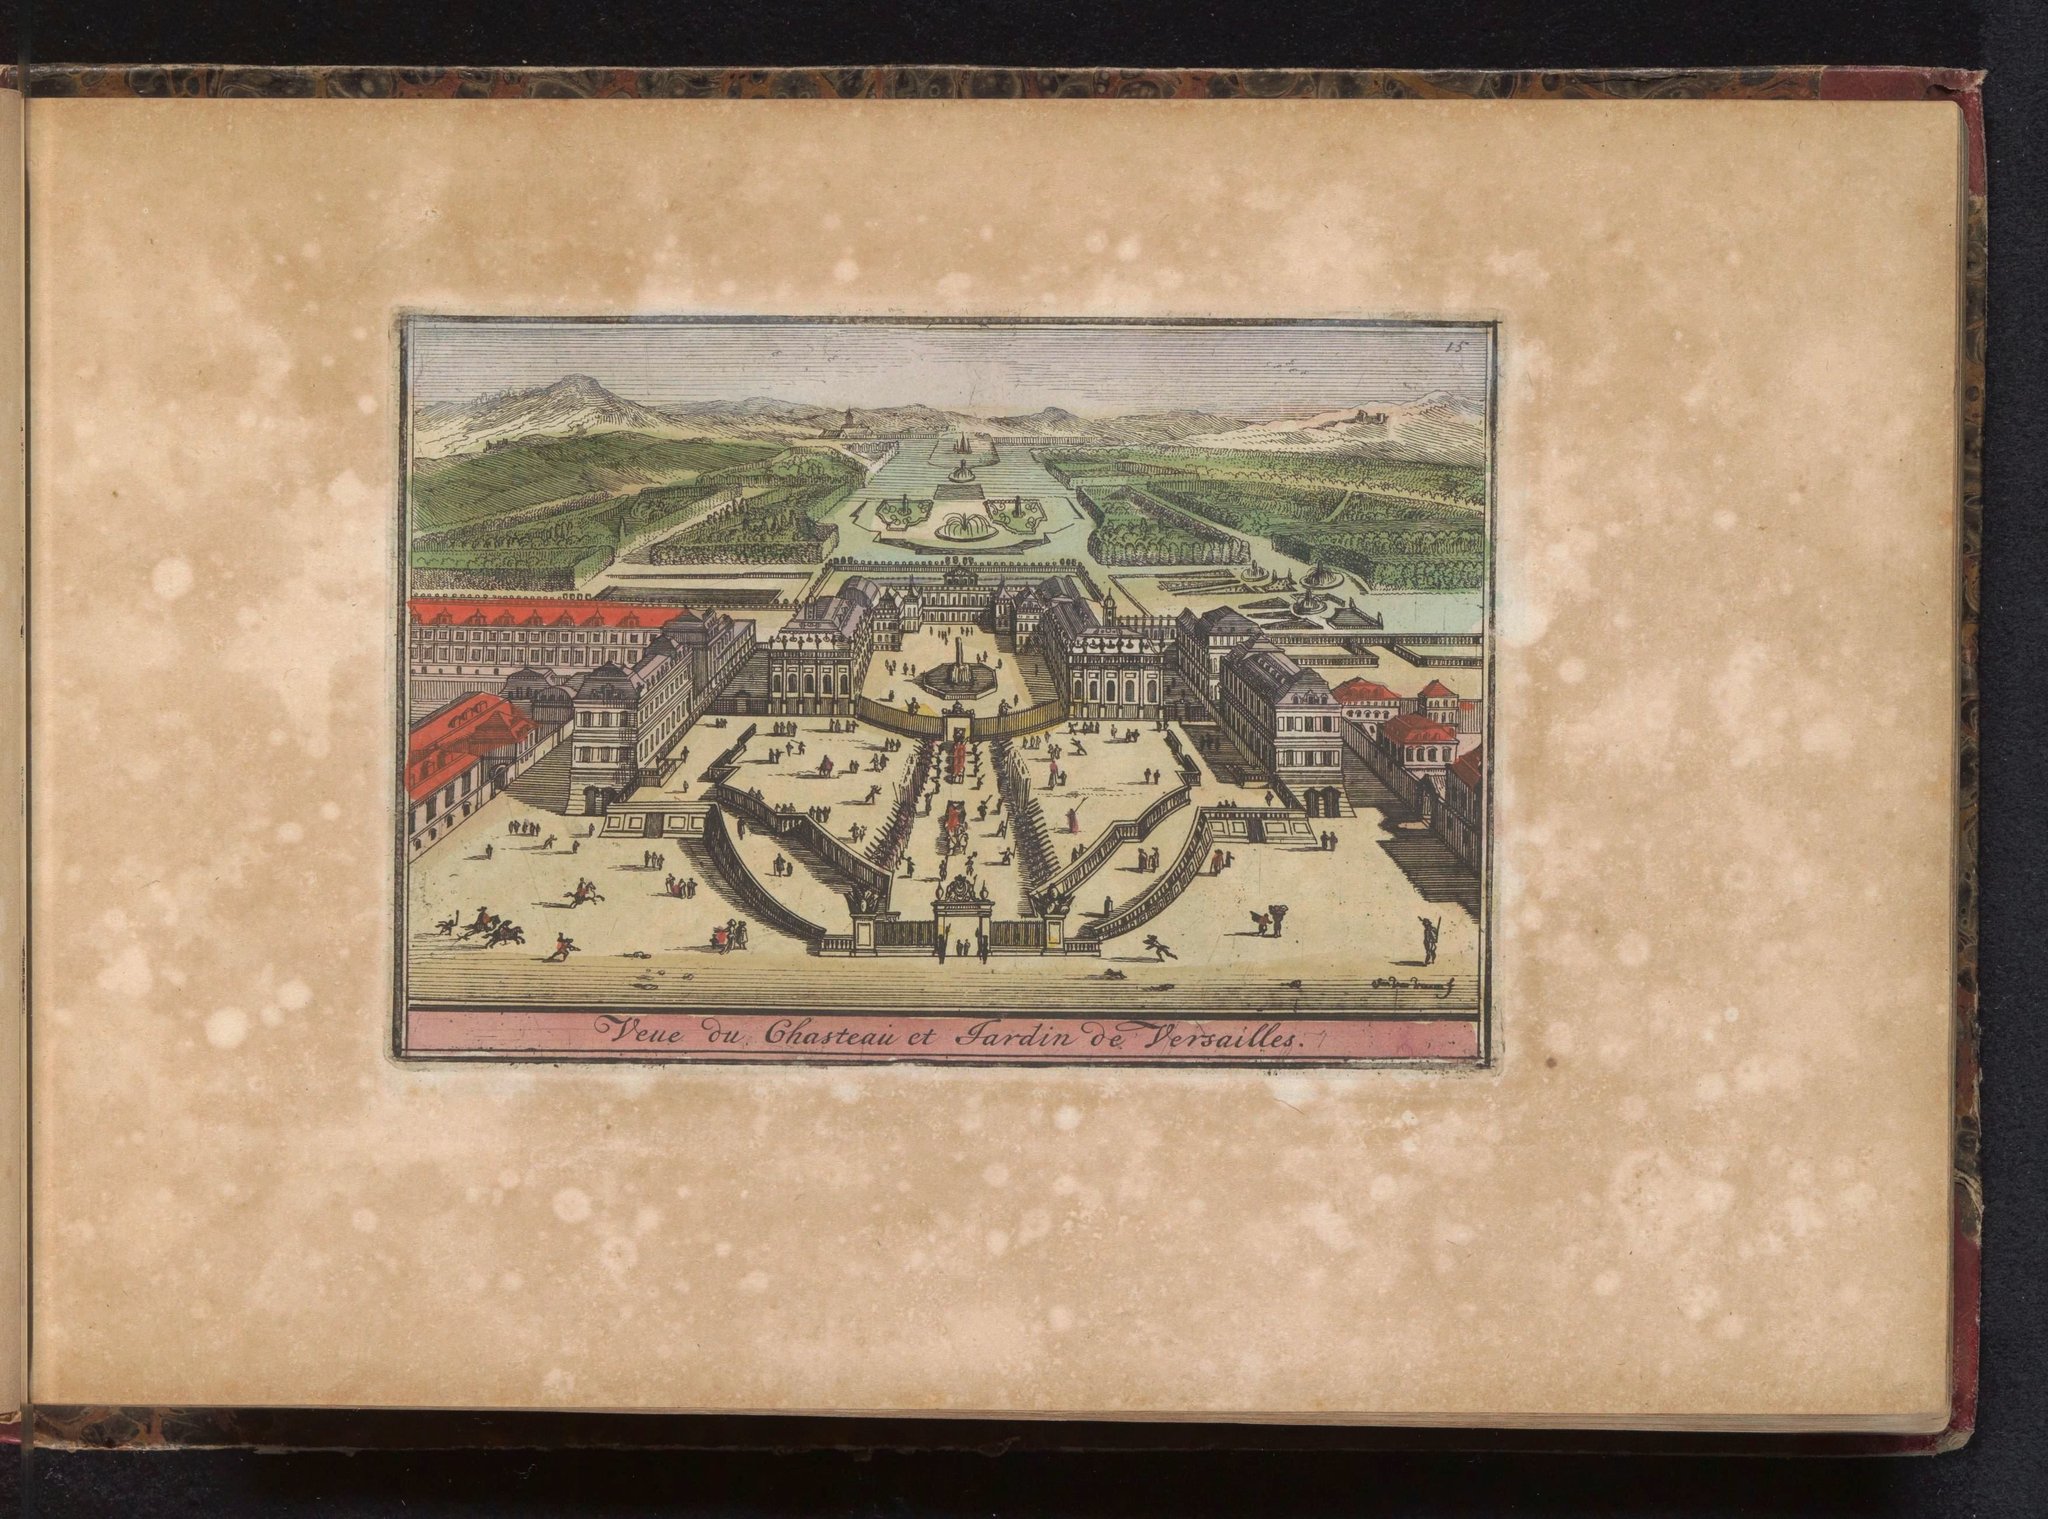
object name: print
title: Paleis en tuinen van Versailles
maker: jan van vianen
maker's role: print maker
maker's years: 1660-1726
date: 1735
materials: paper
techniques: etching, hand coloring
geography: northern netherlands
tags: palace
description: Gezicht op het paleis en de tuinen te Versailles, in vogelvlucht. Onderdeel van een atlas met 223 kaarten van landen en steden en oorlogstaferelen in Europa in de periode ca. 1690-1735.